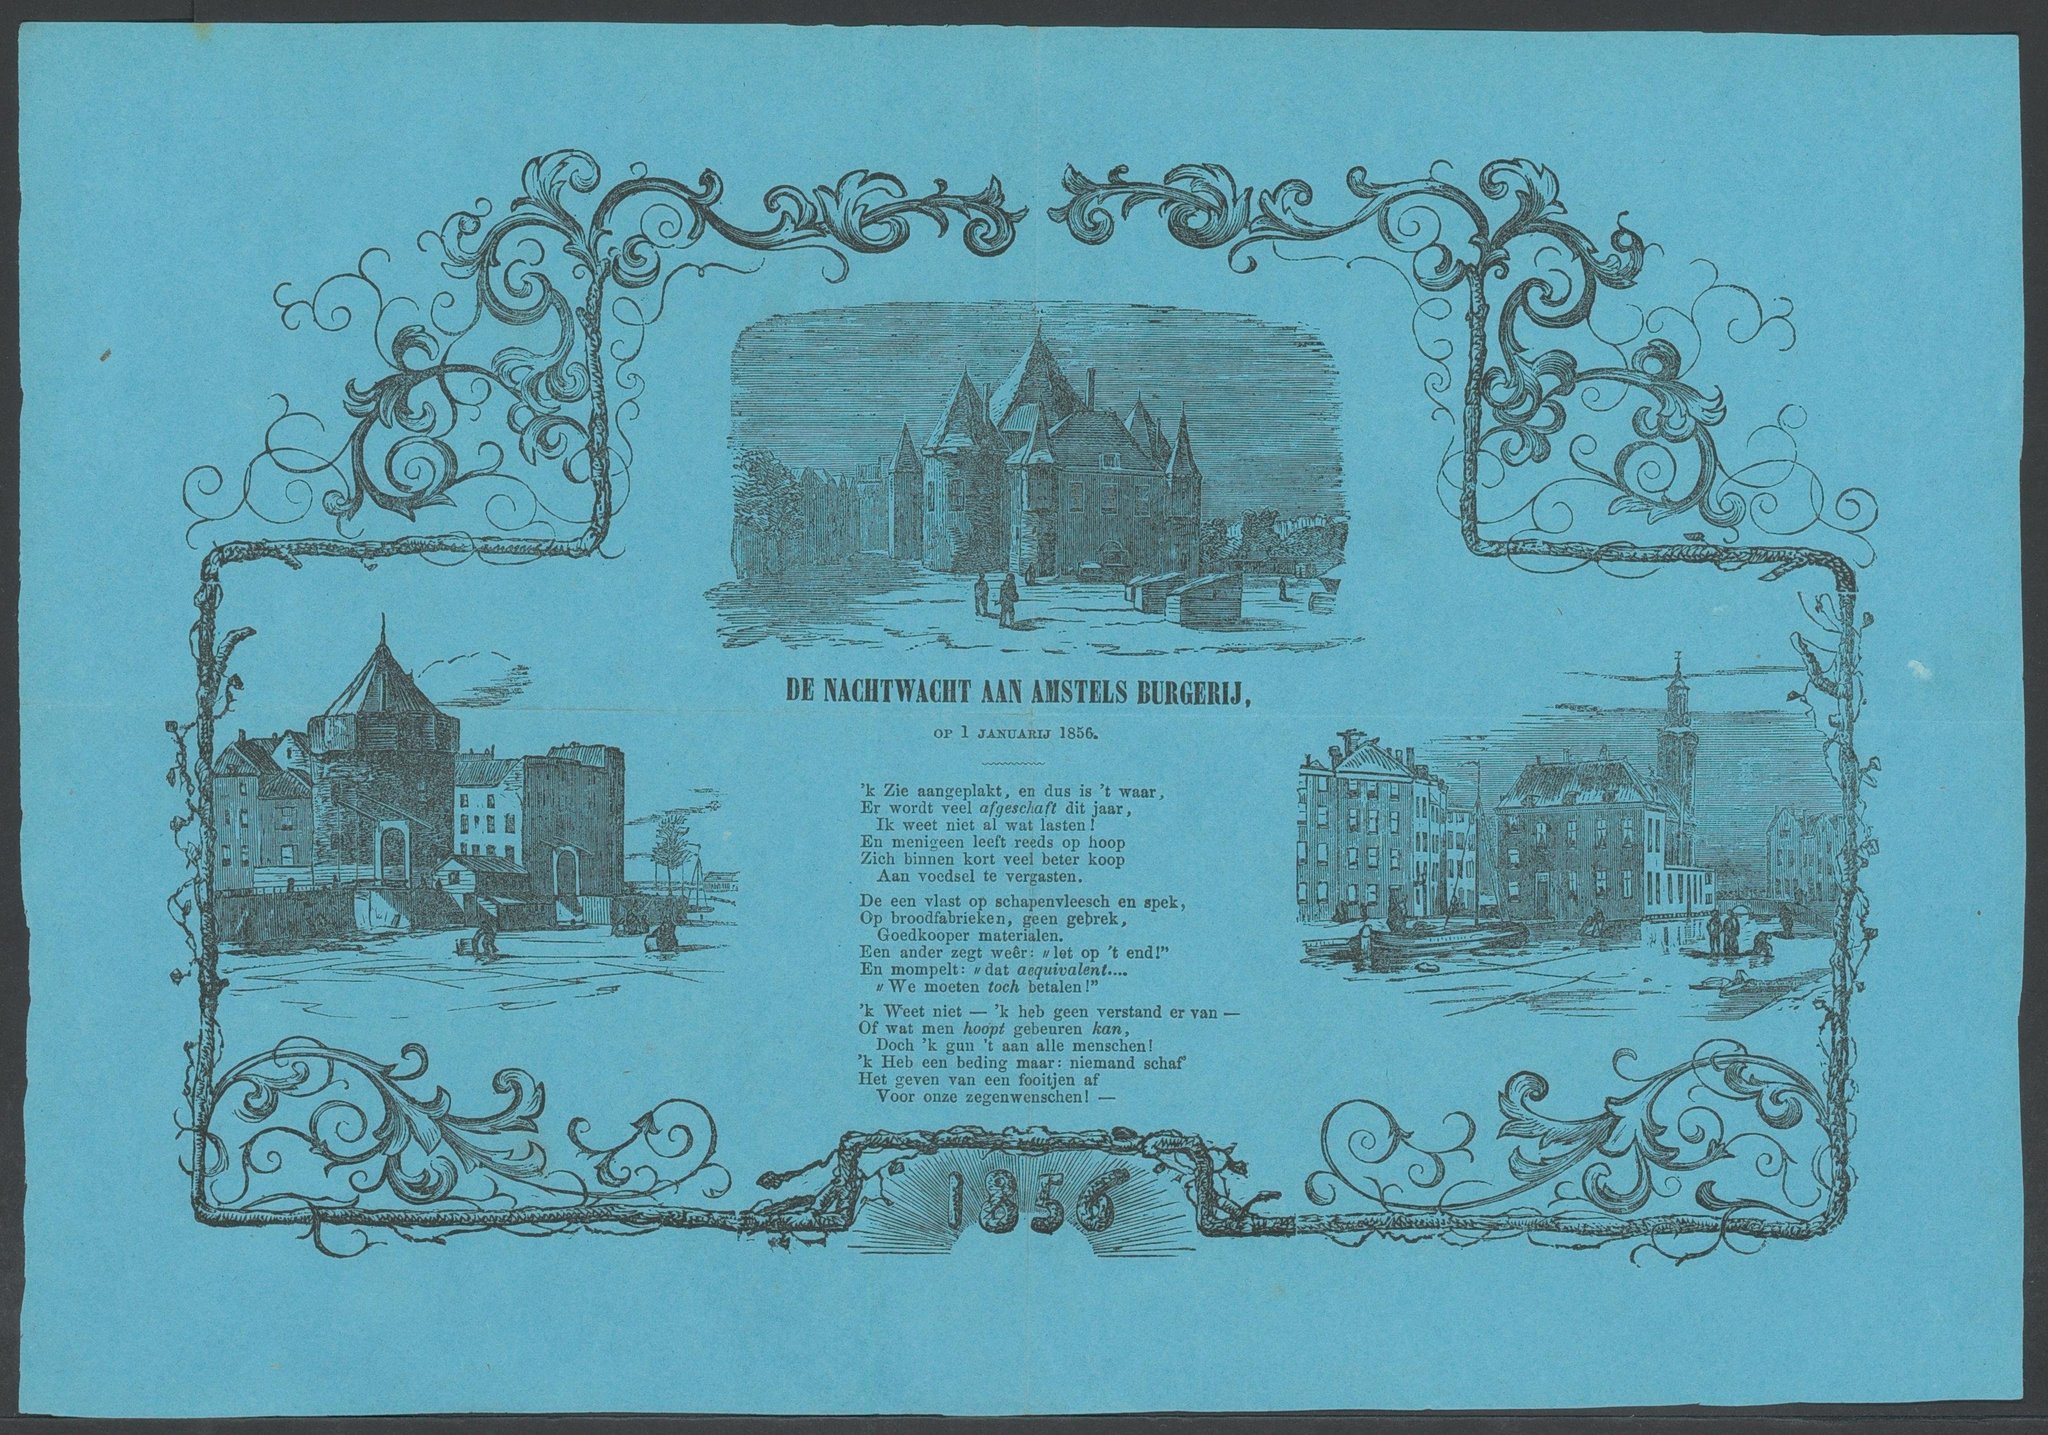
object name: print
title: Nieuwjaarswens van de Amsterdamse nachtwacht voor het jaar 1856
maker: Anonymous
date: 1855-1856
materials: paper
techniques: letterpress printing, engraving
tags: night patrol, tower, clock tower ~ monumental adornment, canal, amsterdam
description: Nieuwjaarswens van de Amsterdamse nachtwacht (ratelwacht) voor het jaar 1856. Centraal een gedicht, daaromheen gezichten op de Waag op de Nieuwmarkt, de Schreierstoren en de Munt. Onderwerpsrubrieken binnen de Atlas Zeden en Gewoonten: Zeden en gewoonten in engeren zin, Volksleven, Volksbladen, Nieuwjaars- en Kerstwenschen, Amsterdam.